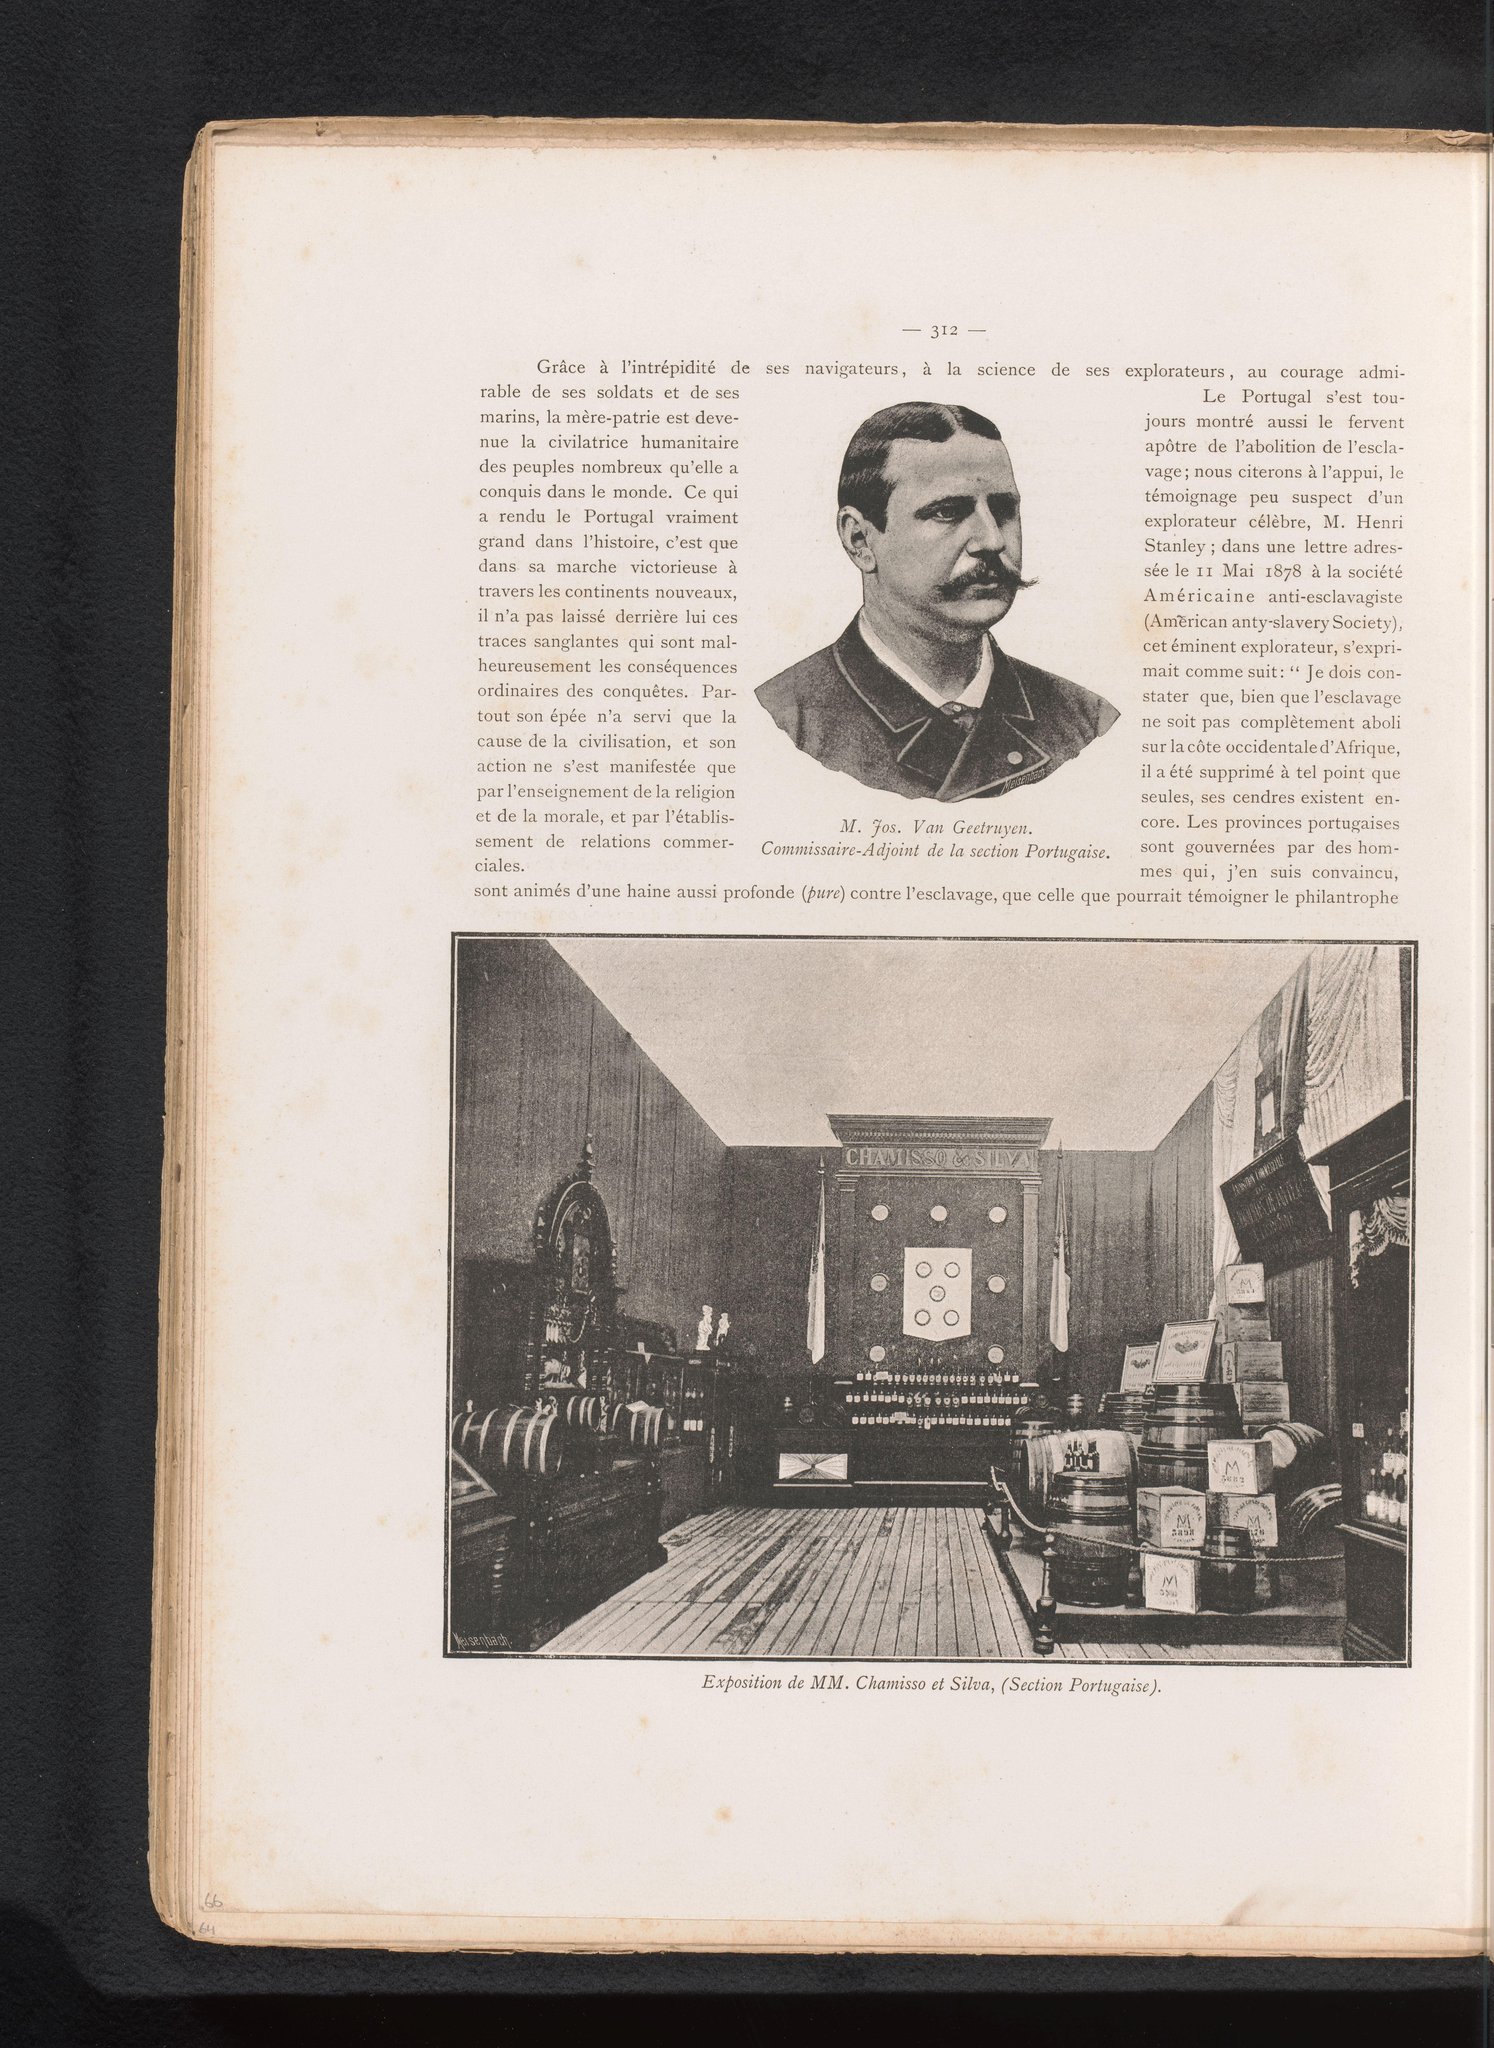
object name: page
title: Exposition de MM. Chamisso et Silva, (Section Portugaise)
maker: Anonymous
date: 1880-1885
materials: paper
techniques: autotype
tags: world fair, world exhibition, historical persons, antwerp